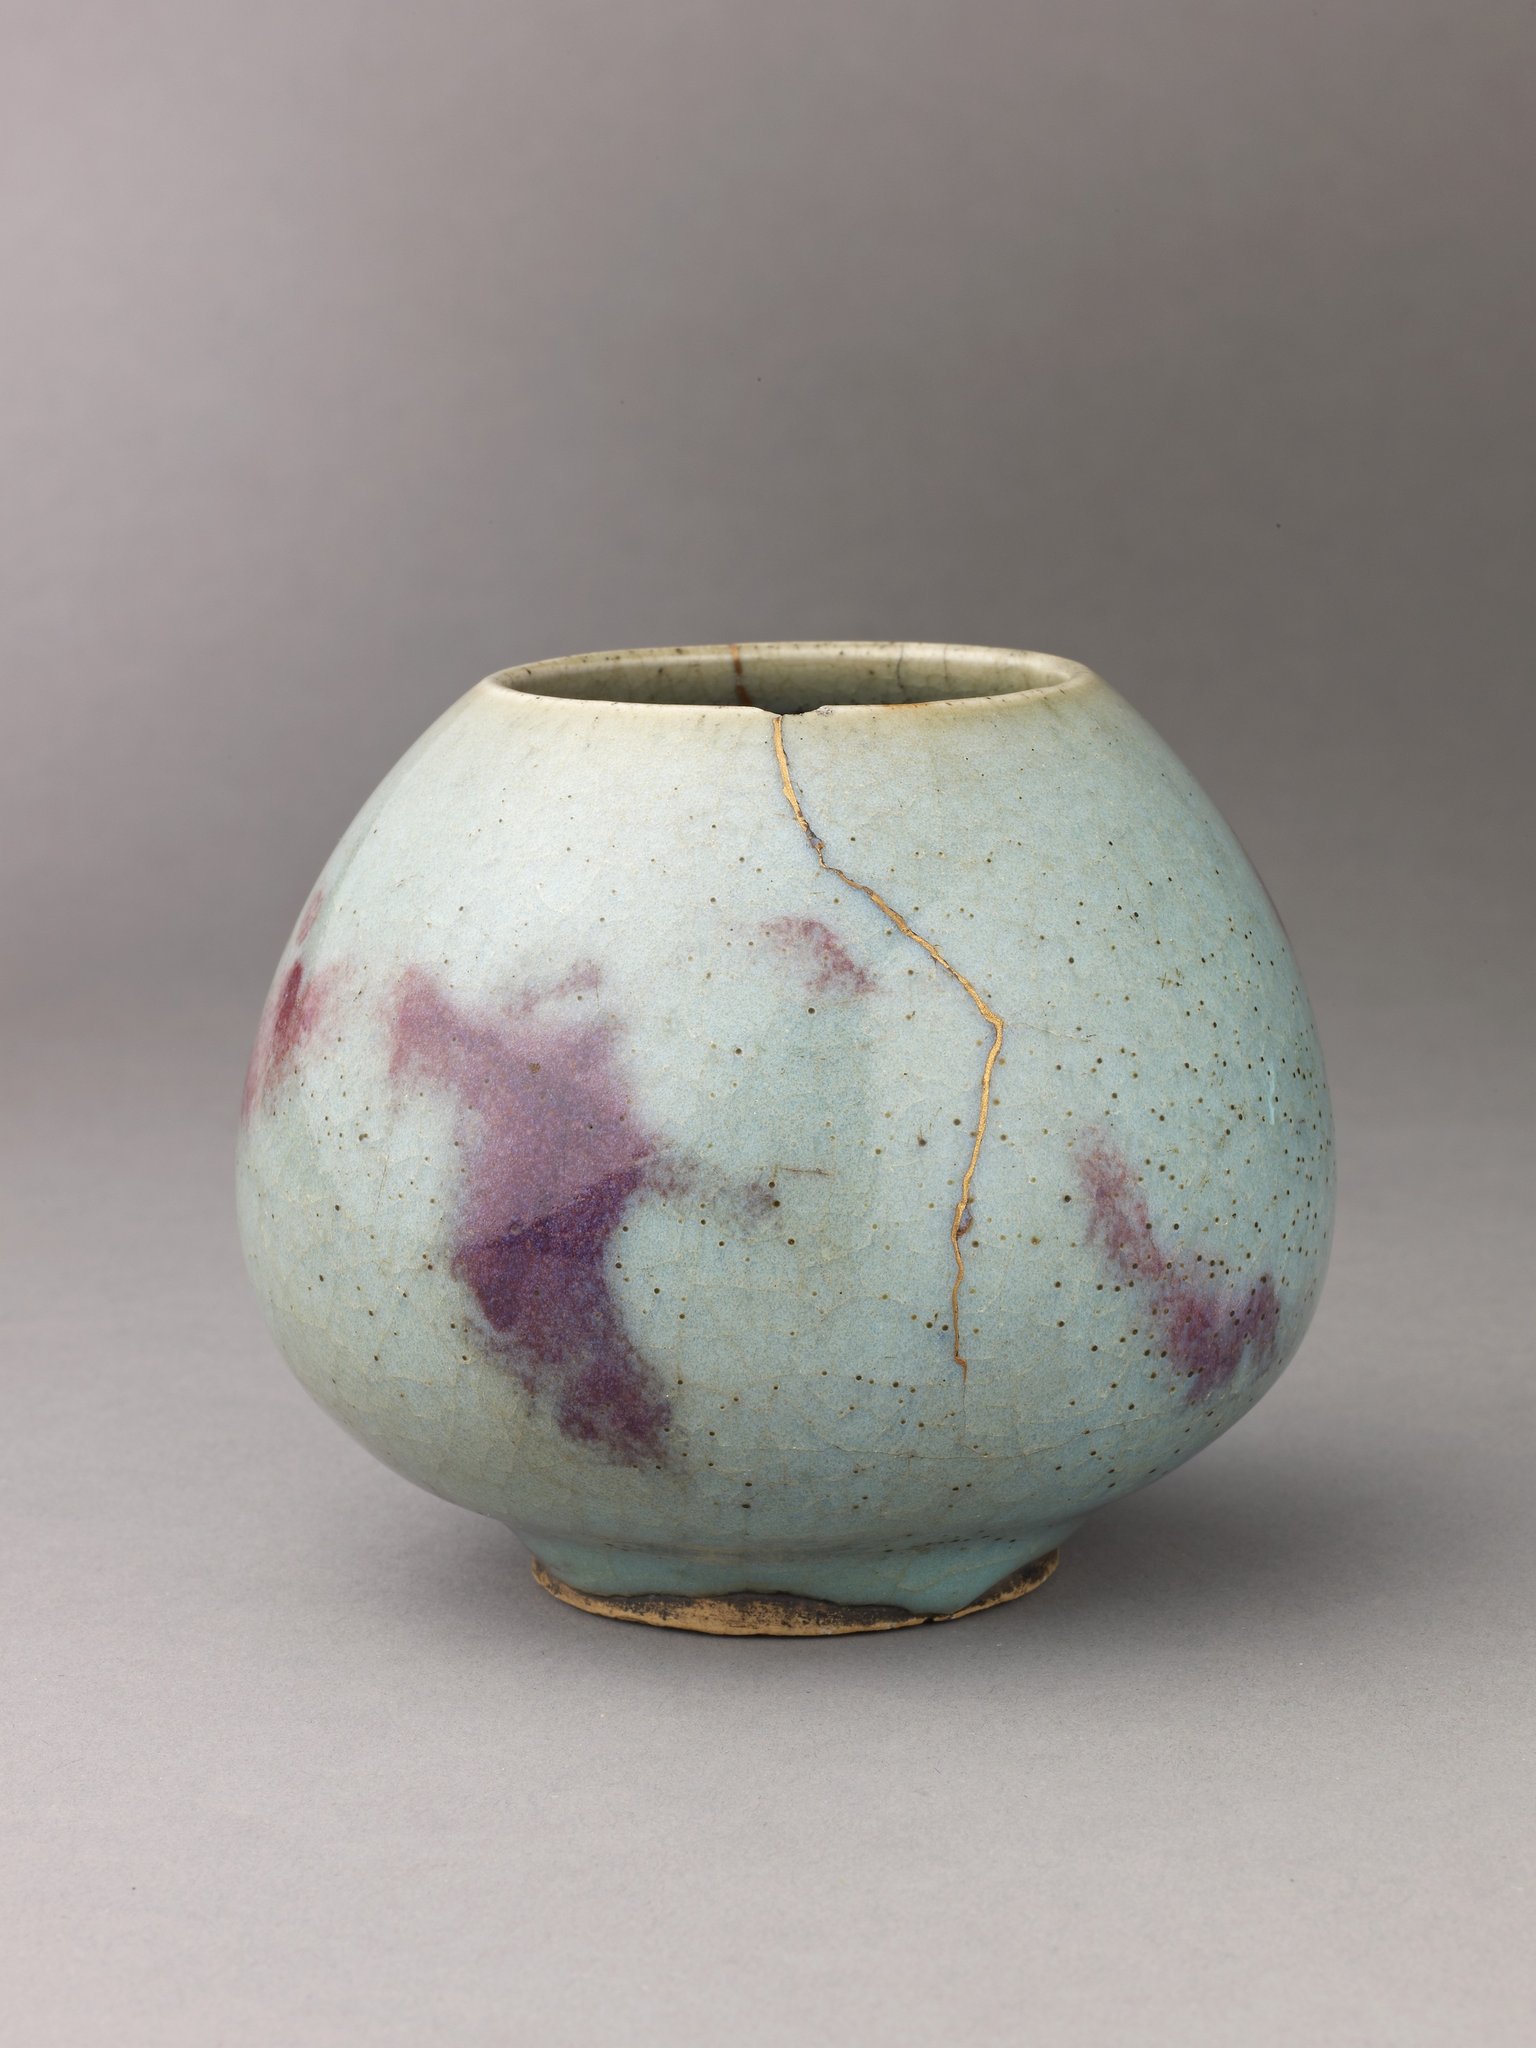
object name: jar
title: Jar, Jun ware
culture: chinese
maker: chinese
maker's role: artist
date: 1201-1300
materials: glaze, stoneware